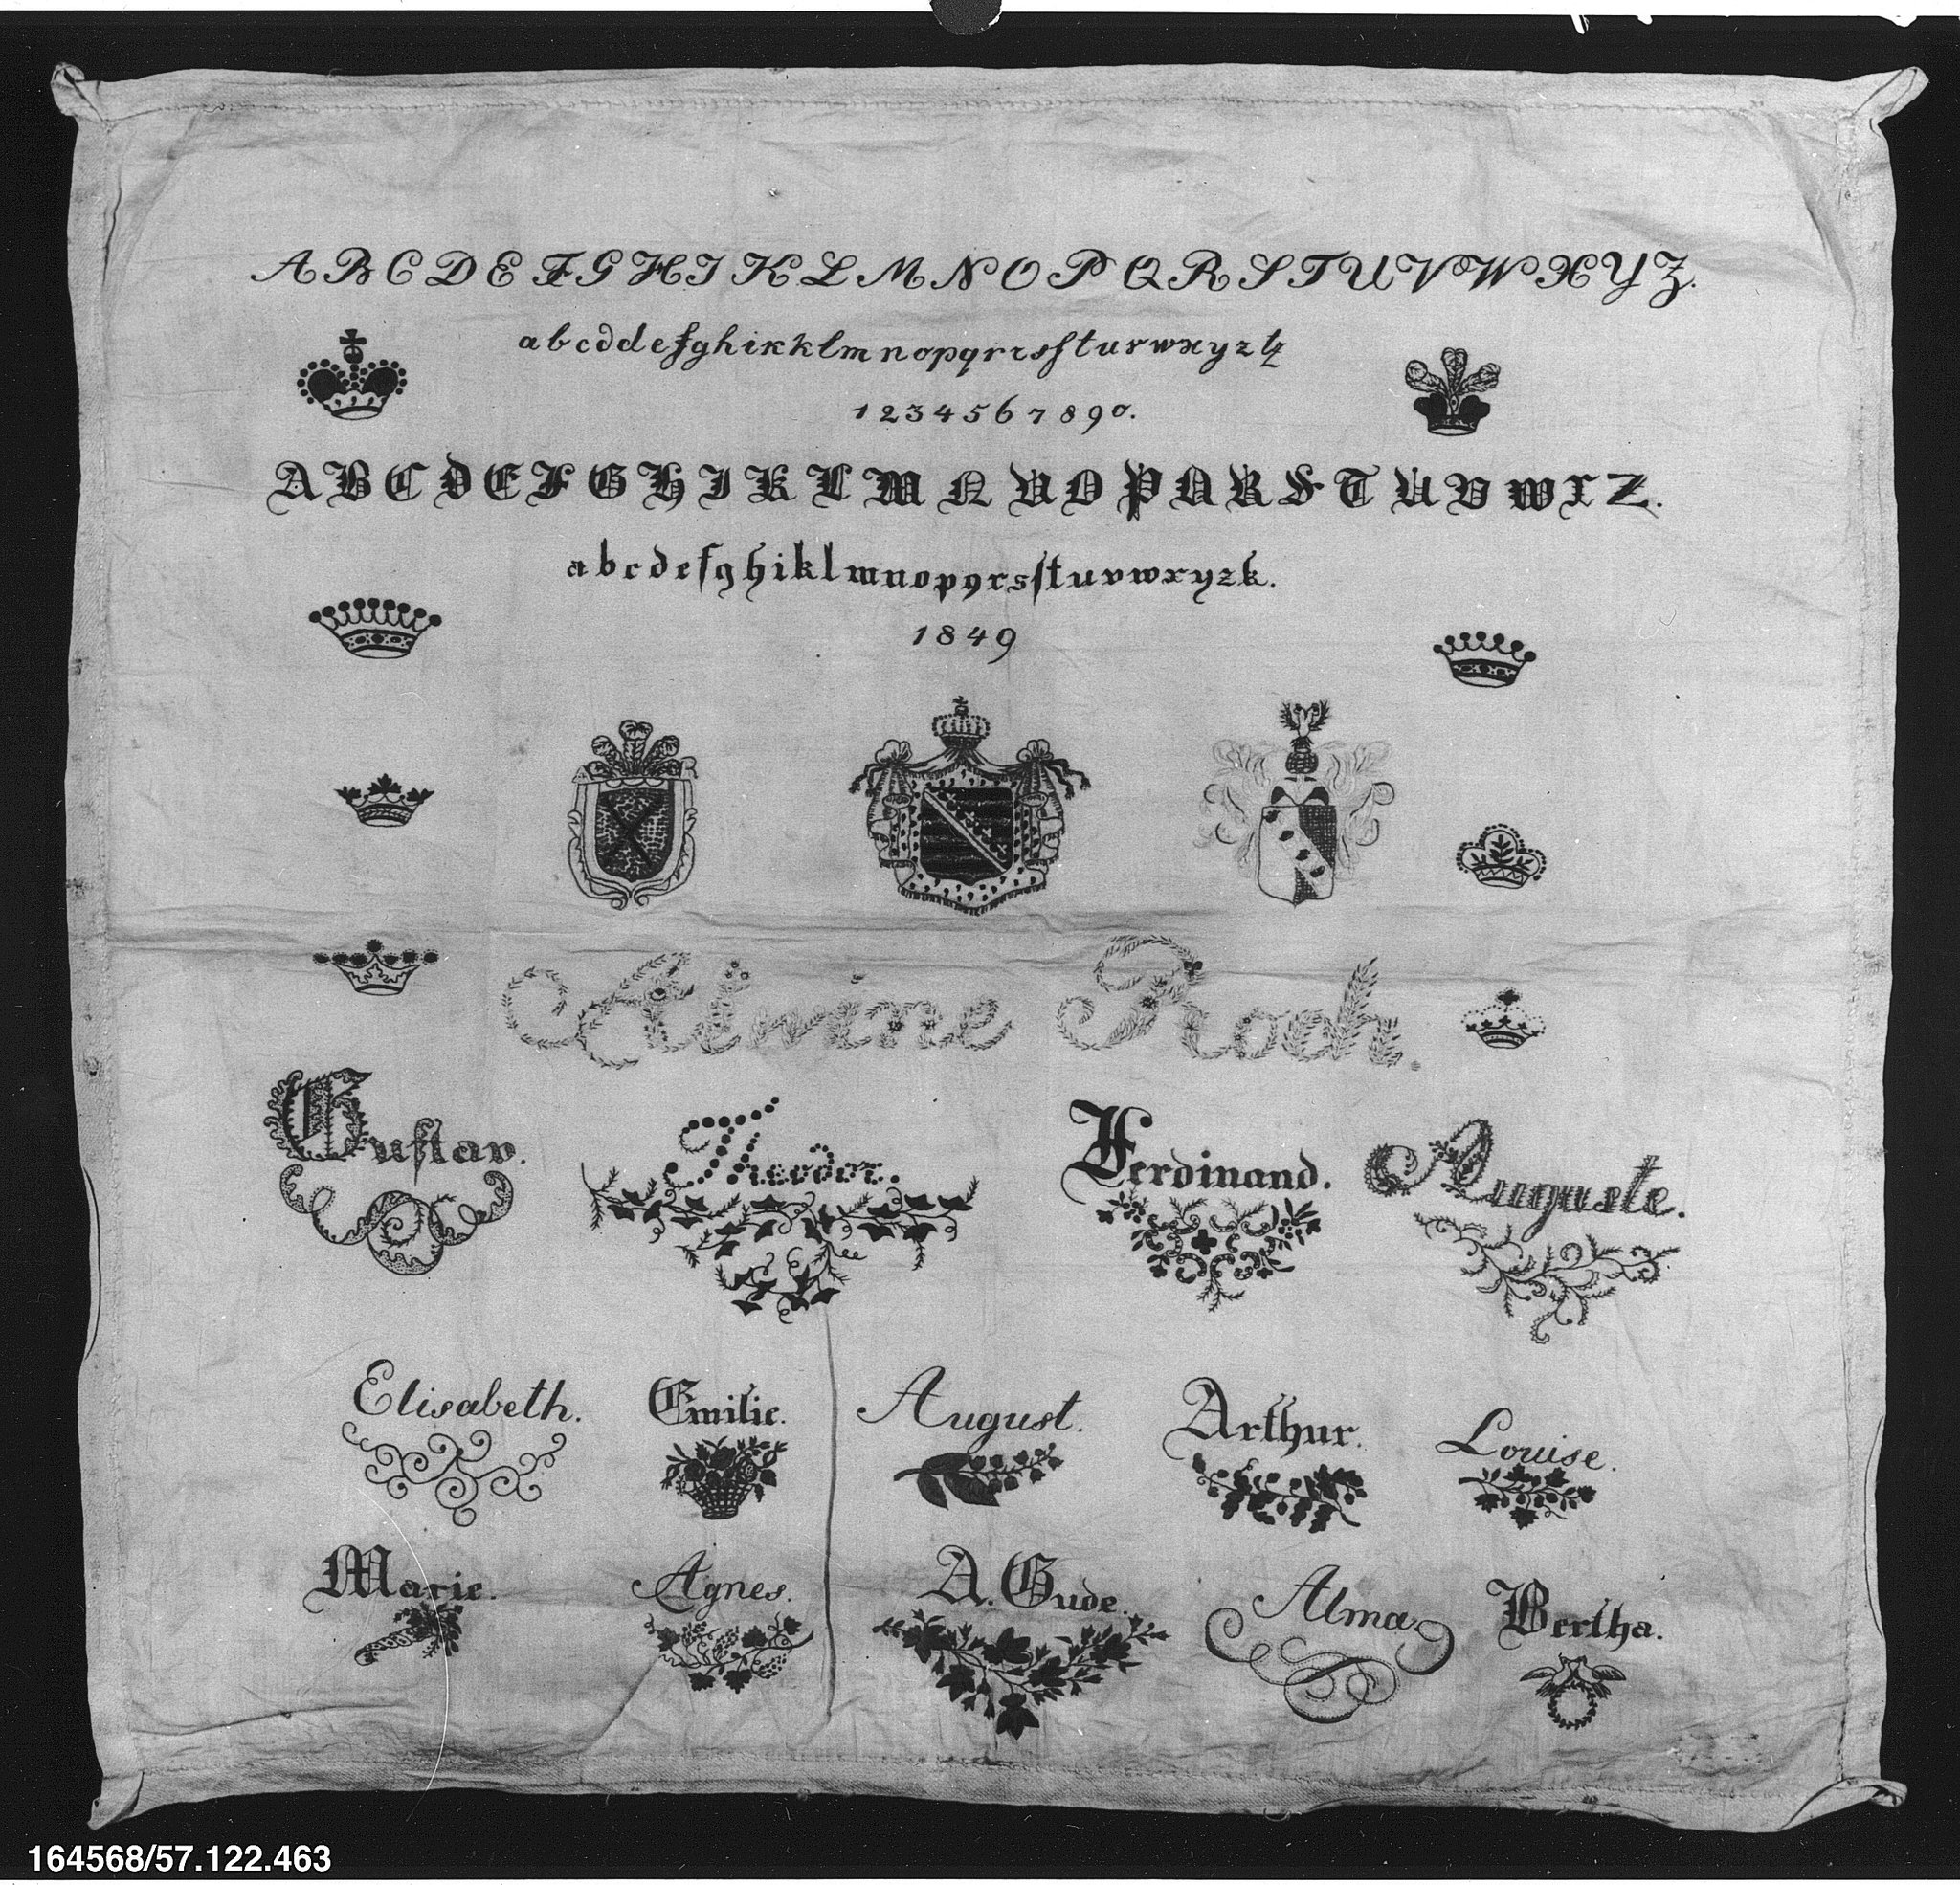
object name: sampler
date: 1849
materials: cotton, linen, metal thread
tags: coat of arms,crowns